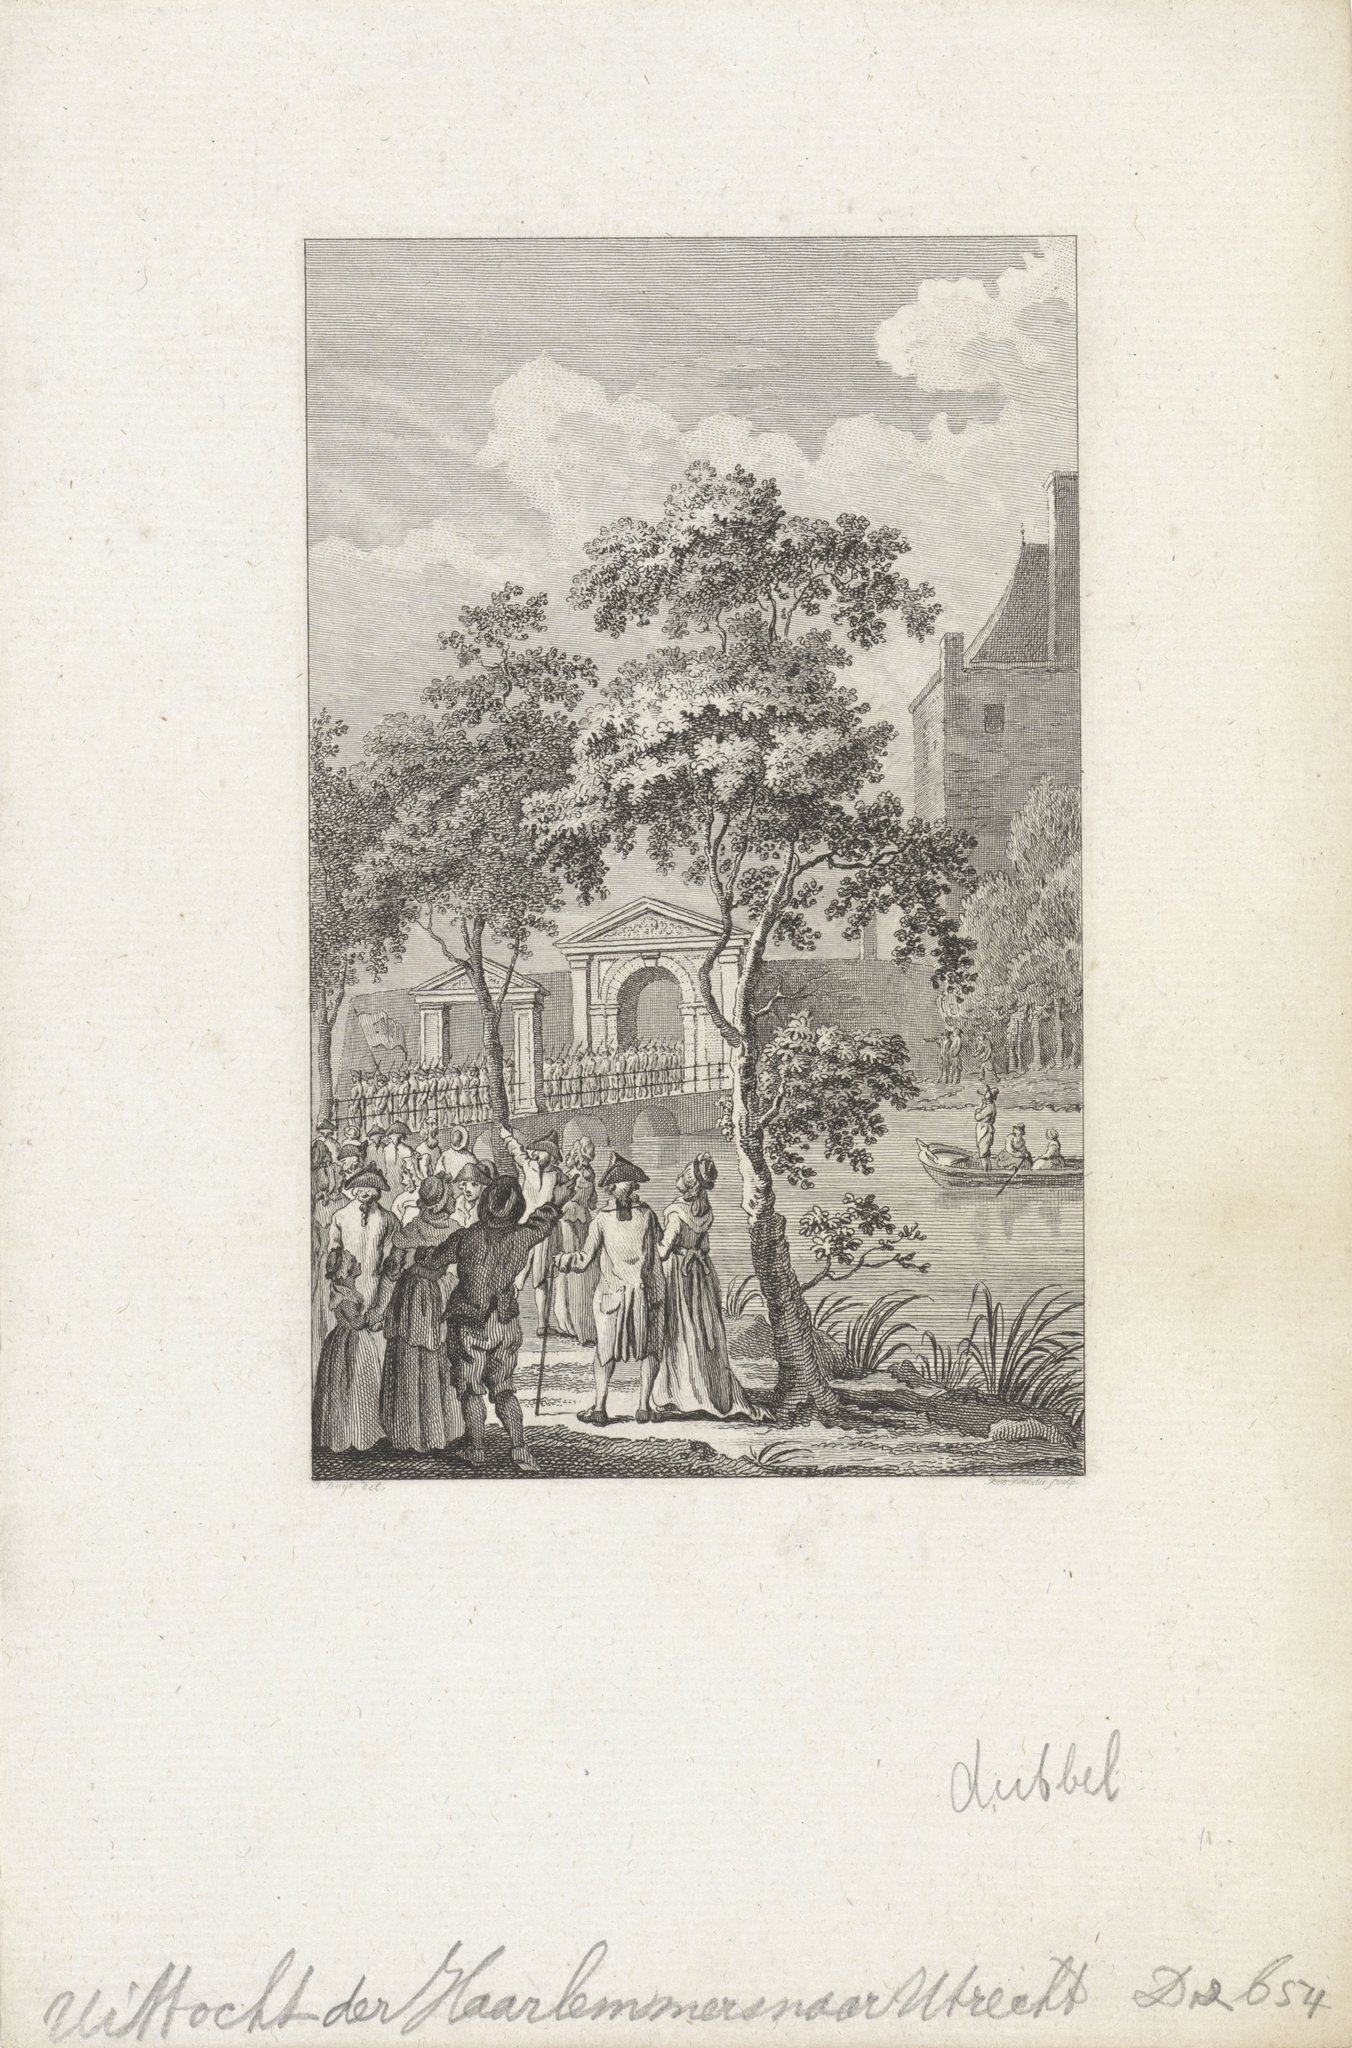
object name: print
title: Haarlemse burgers trekken op naar Utrecht, 1786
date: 1794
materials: paper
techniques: engraving, etching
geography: amsterdam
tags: troop movements, transportation (+ citizen soldiery, civil guard, citizen militia), haarlem, patriots (1780-1795)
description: Gebruikt als illustratie in: P.A. Loosjes, Vaderlandsche historie, vervattende de geschiedenissen, der Vereenigde Nederlanden (...). Ten onmiddelyken vervolge van Wagenaar's Vaderlandsche historie, dl. 12.